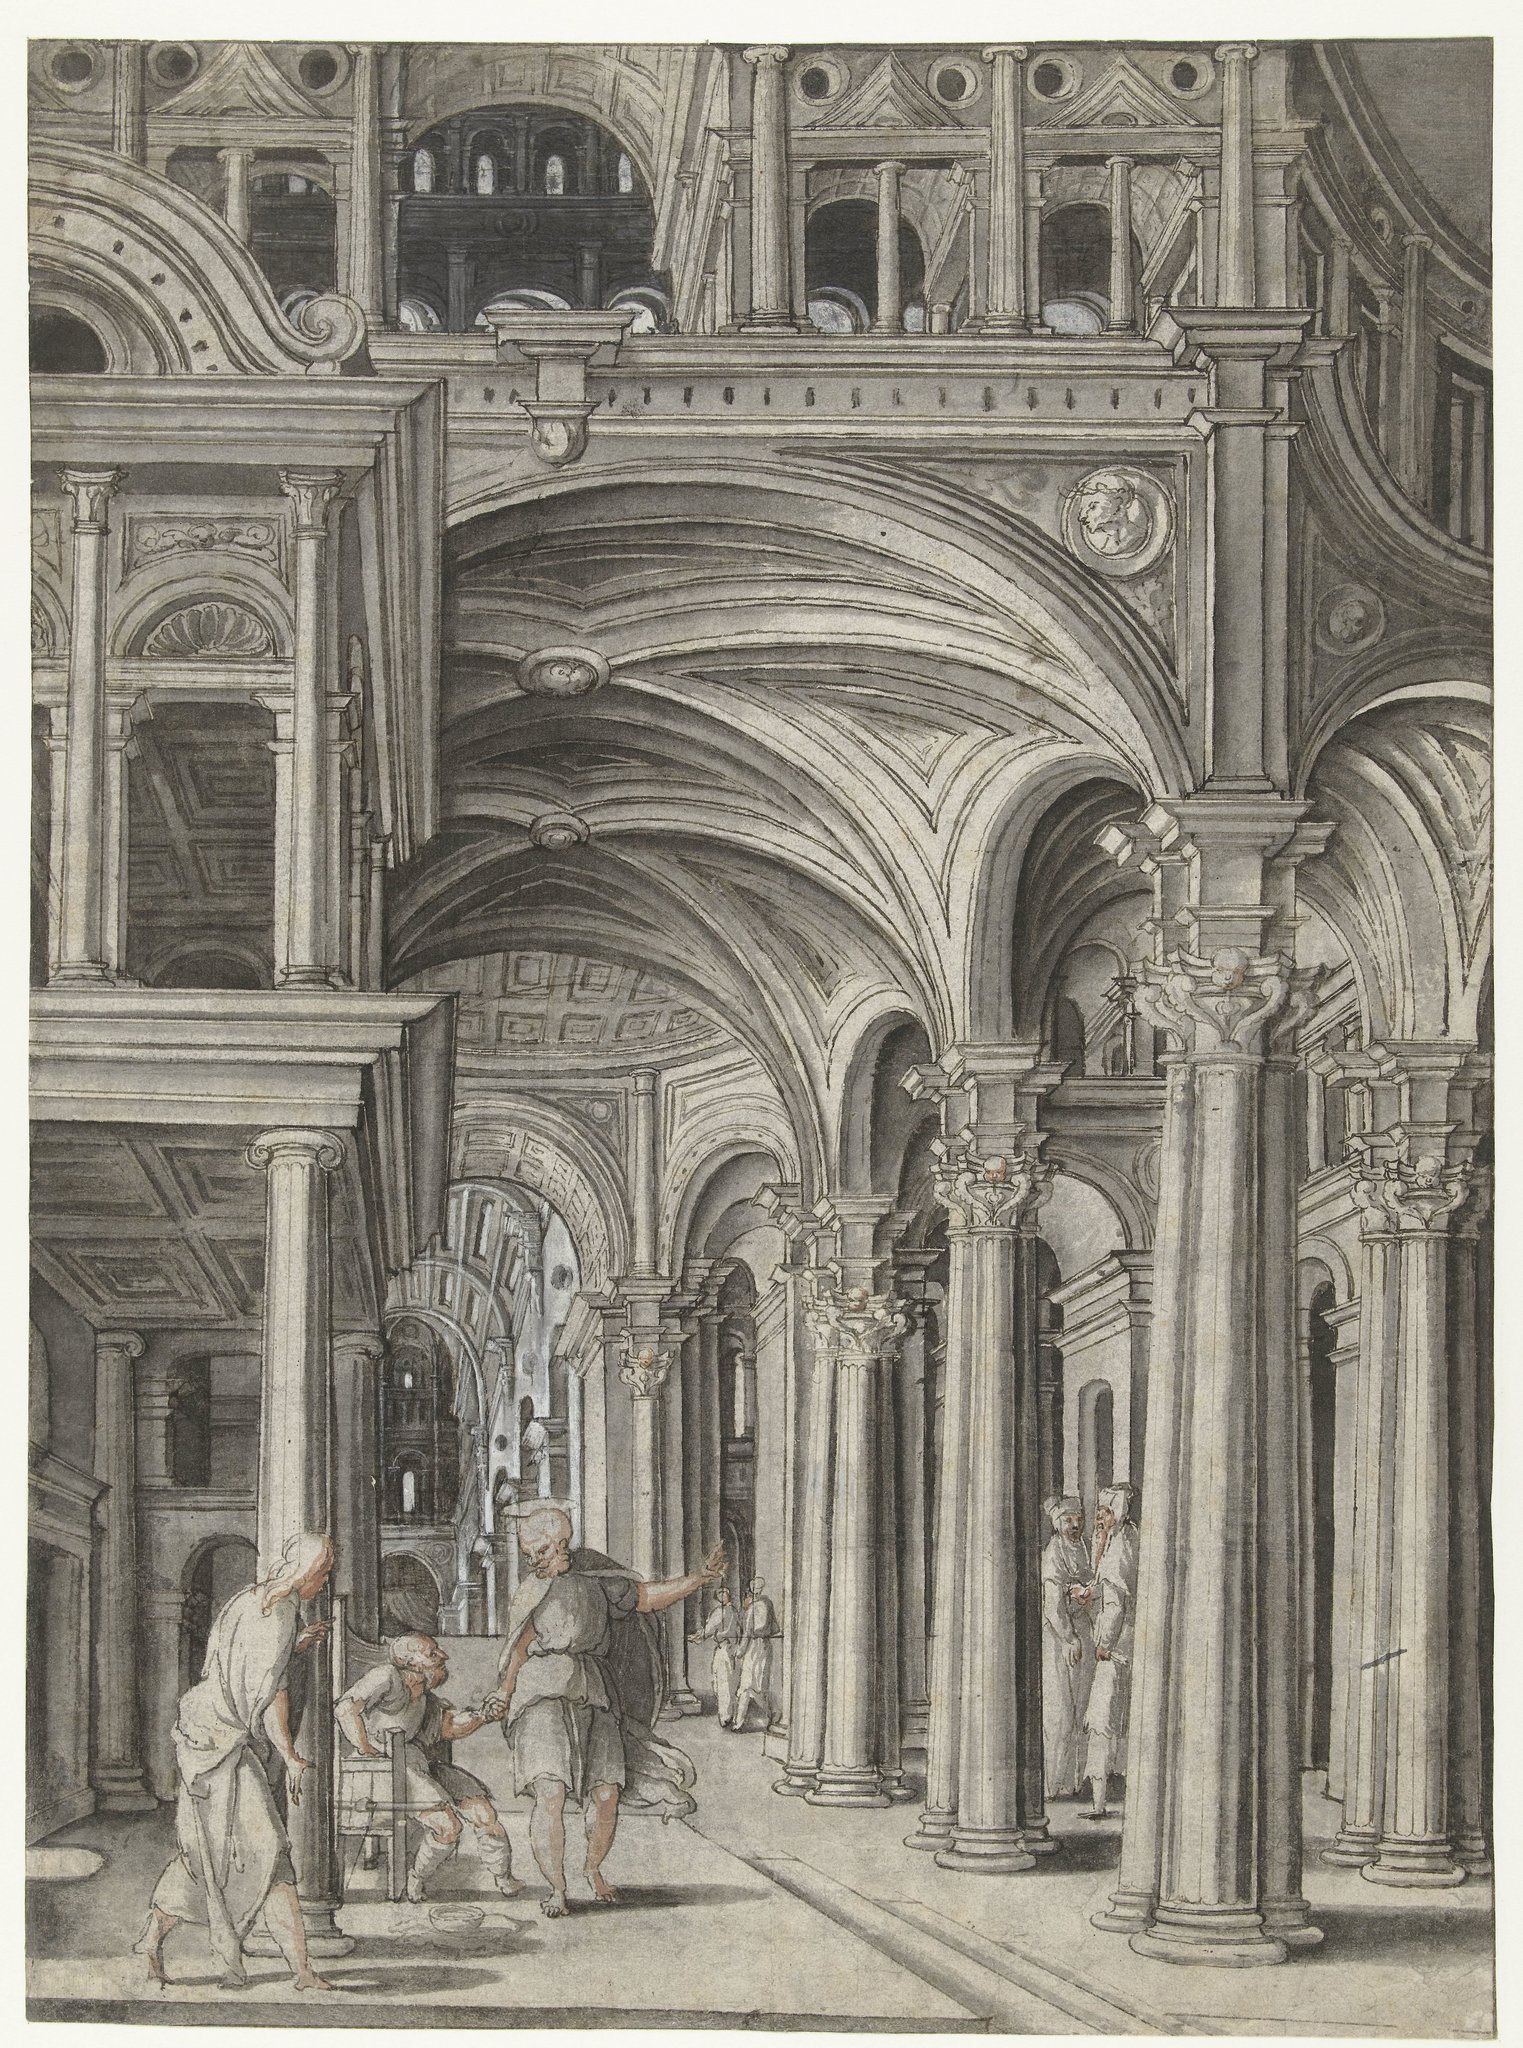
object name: drawing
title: Petrus geneest de kreupele in de tempel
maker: aertgen claesz van leyden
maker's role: draughtsman, painter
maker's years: 1498-1564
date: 1508-1564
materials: paint, paper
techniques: brush, pen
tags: healing of a lame beggar at the beautiful gate of the temple by peter and john (acts 3 - 4:31), disabilities, deformations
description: De voorstelling is gebaseerd op de tekst uit Handelingen 3:4-31.